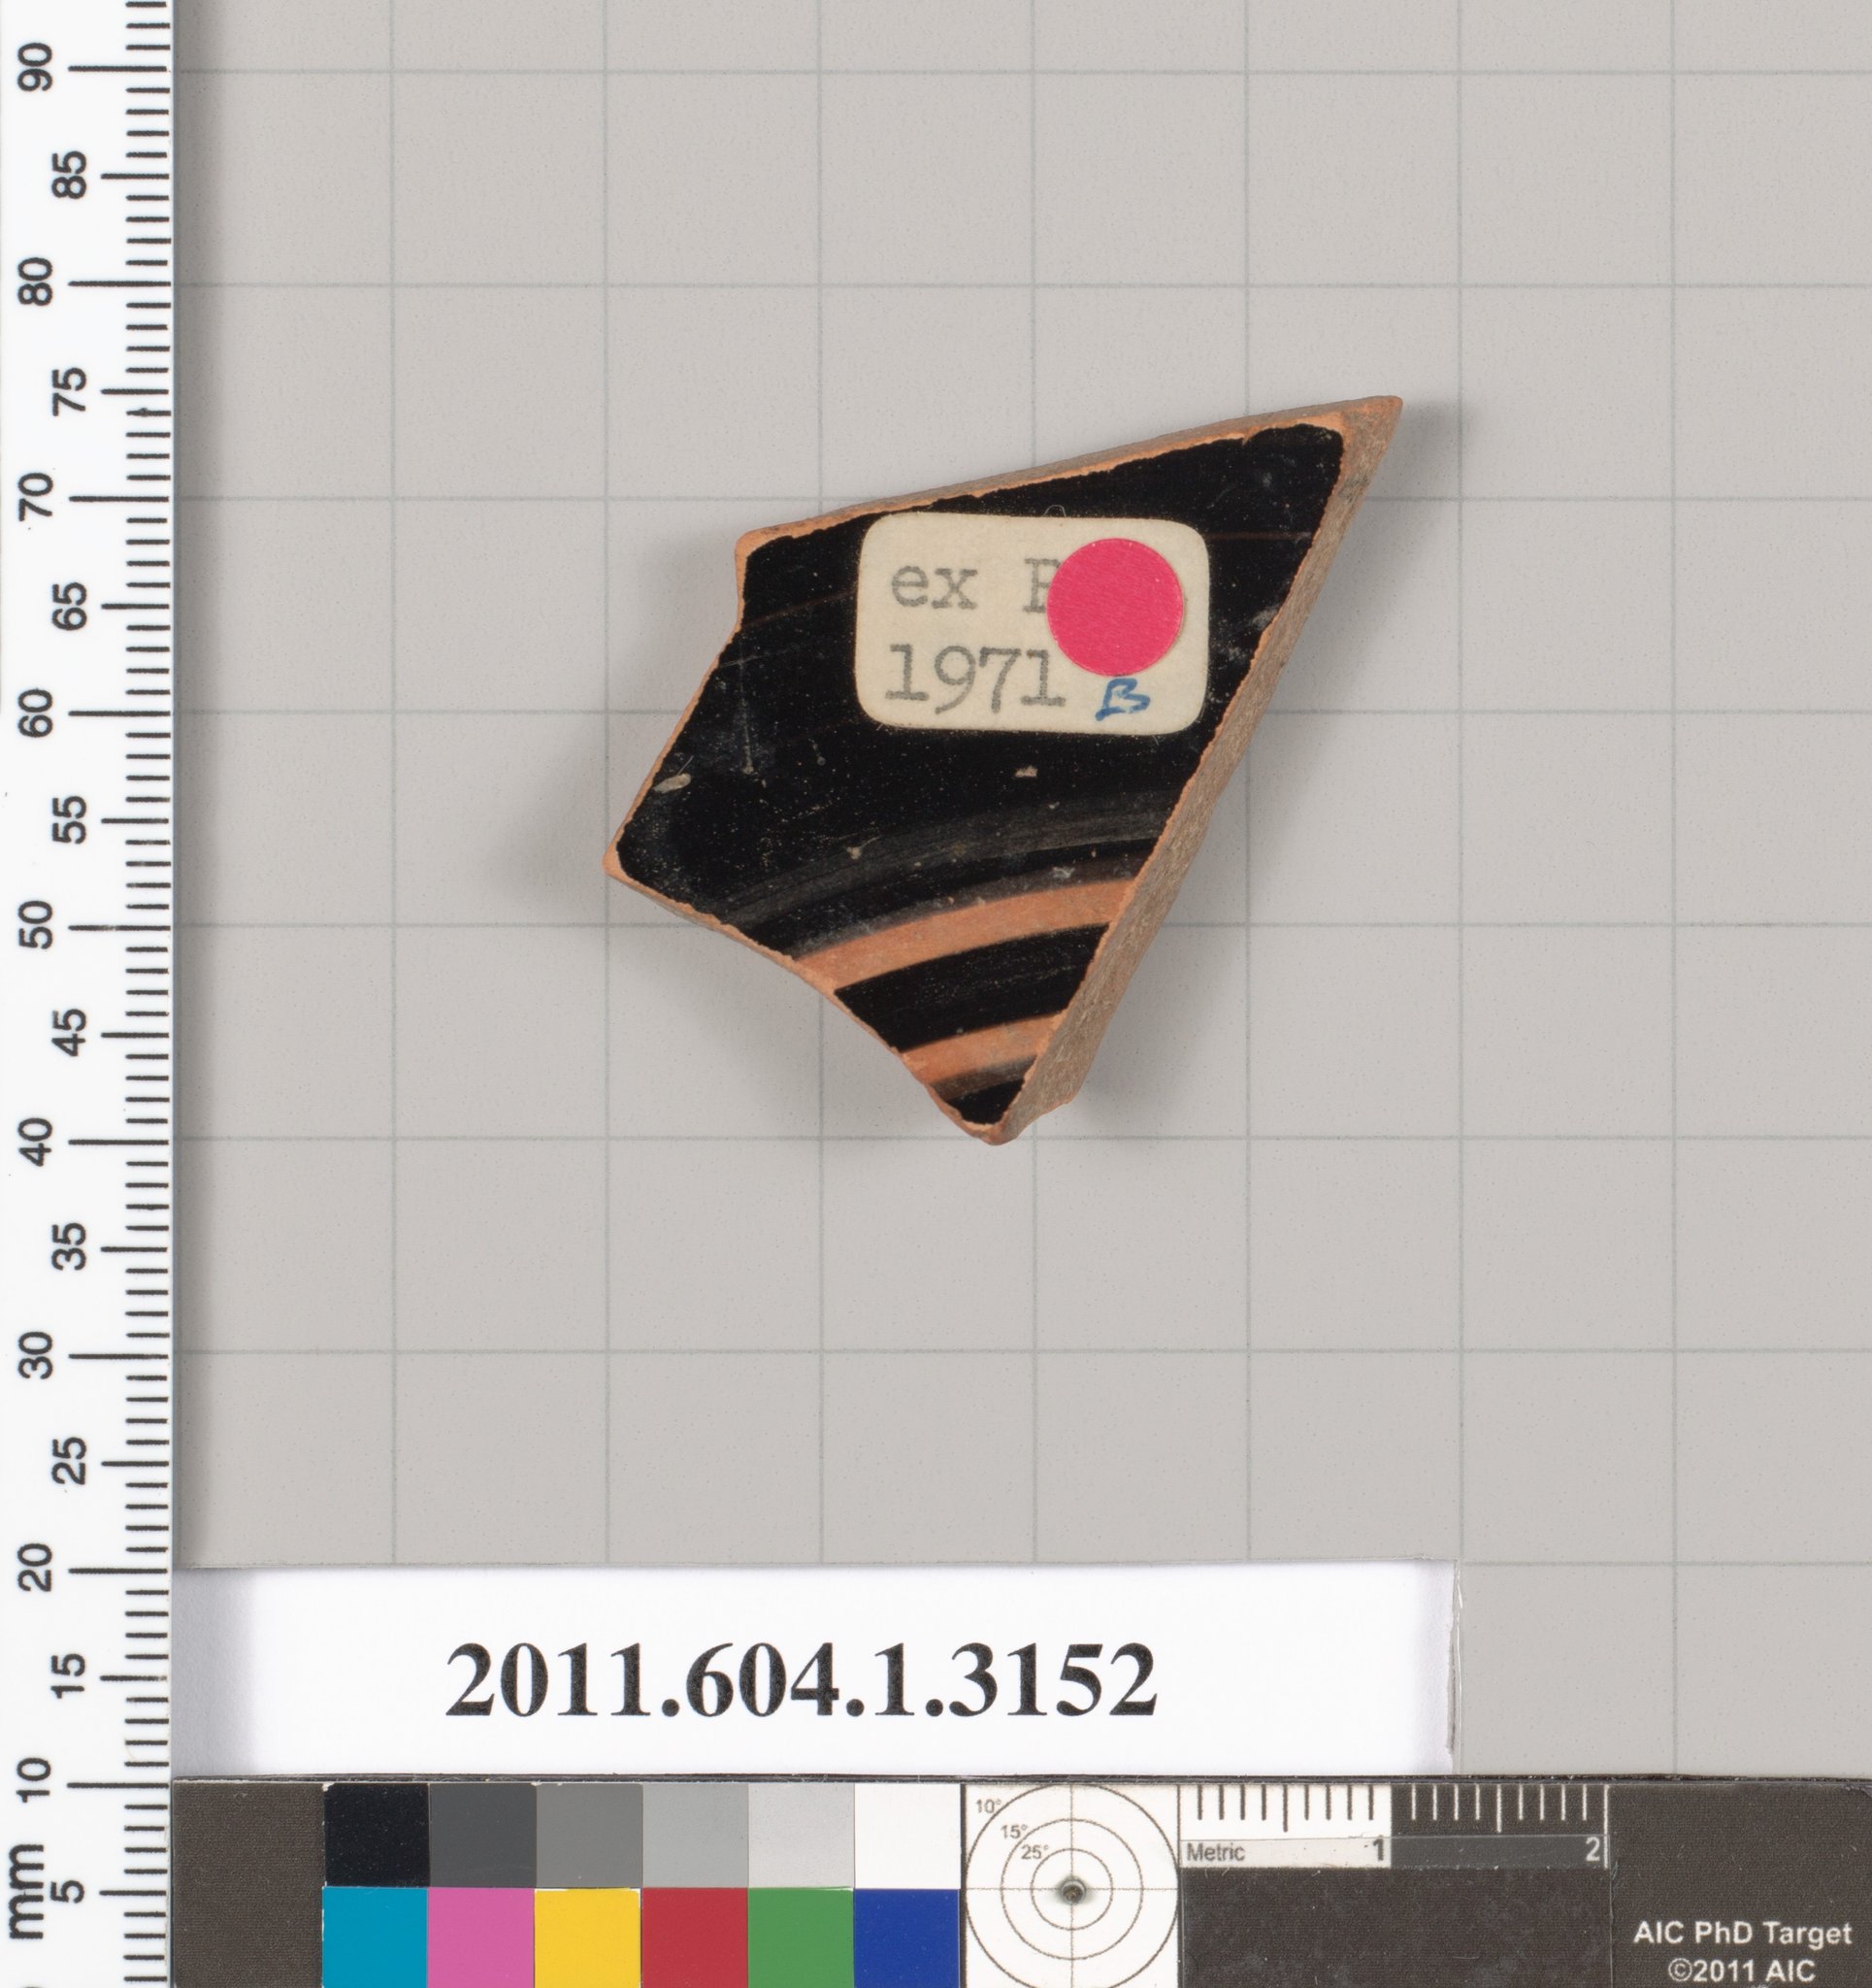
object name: kylix fragment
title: Terracotta fragment of a kylix (drinking cup)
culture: greek, attic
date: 450-426 BCE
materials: terracotta